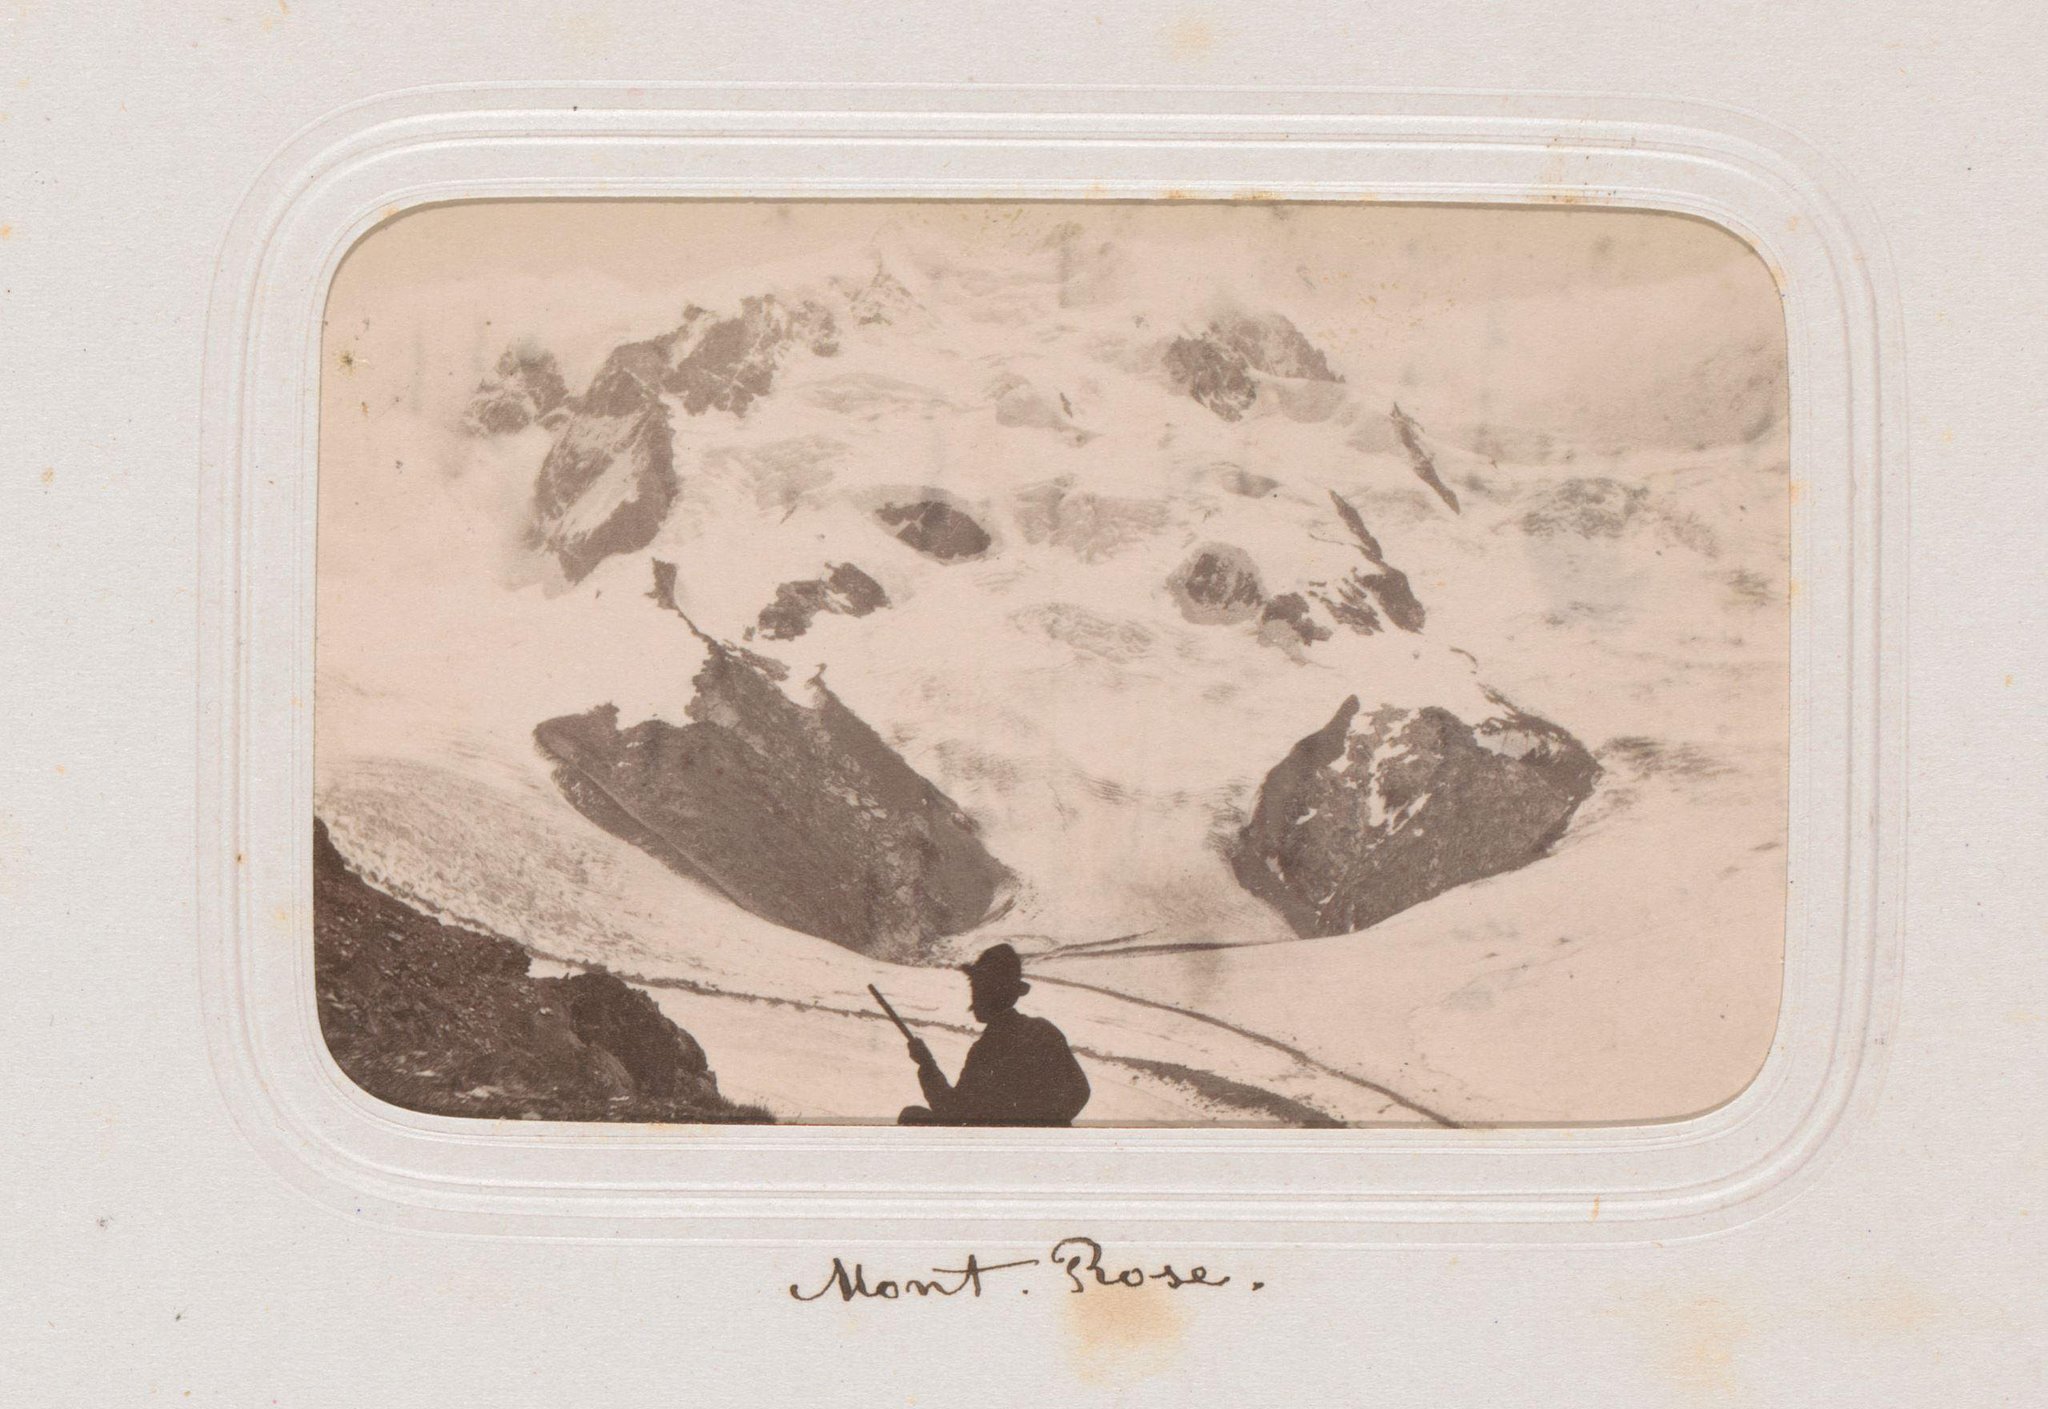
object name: carte de visite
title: Le Mont Rose vue prise du Gornegrat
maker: florentin charnaux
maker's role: publisher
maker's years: 1819-1883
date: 1871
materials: cardboard, paper, photographic support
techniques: albumen print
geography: alps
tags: mountain climbing, mountaineering, mountains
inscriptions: number: ‘113’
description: Onderdeel van Reisalbum met foto's van bezienswaardigheden in Zwitserland.